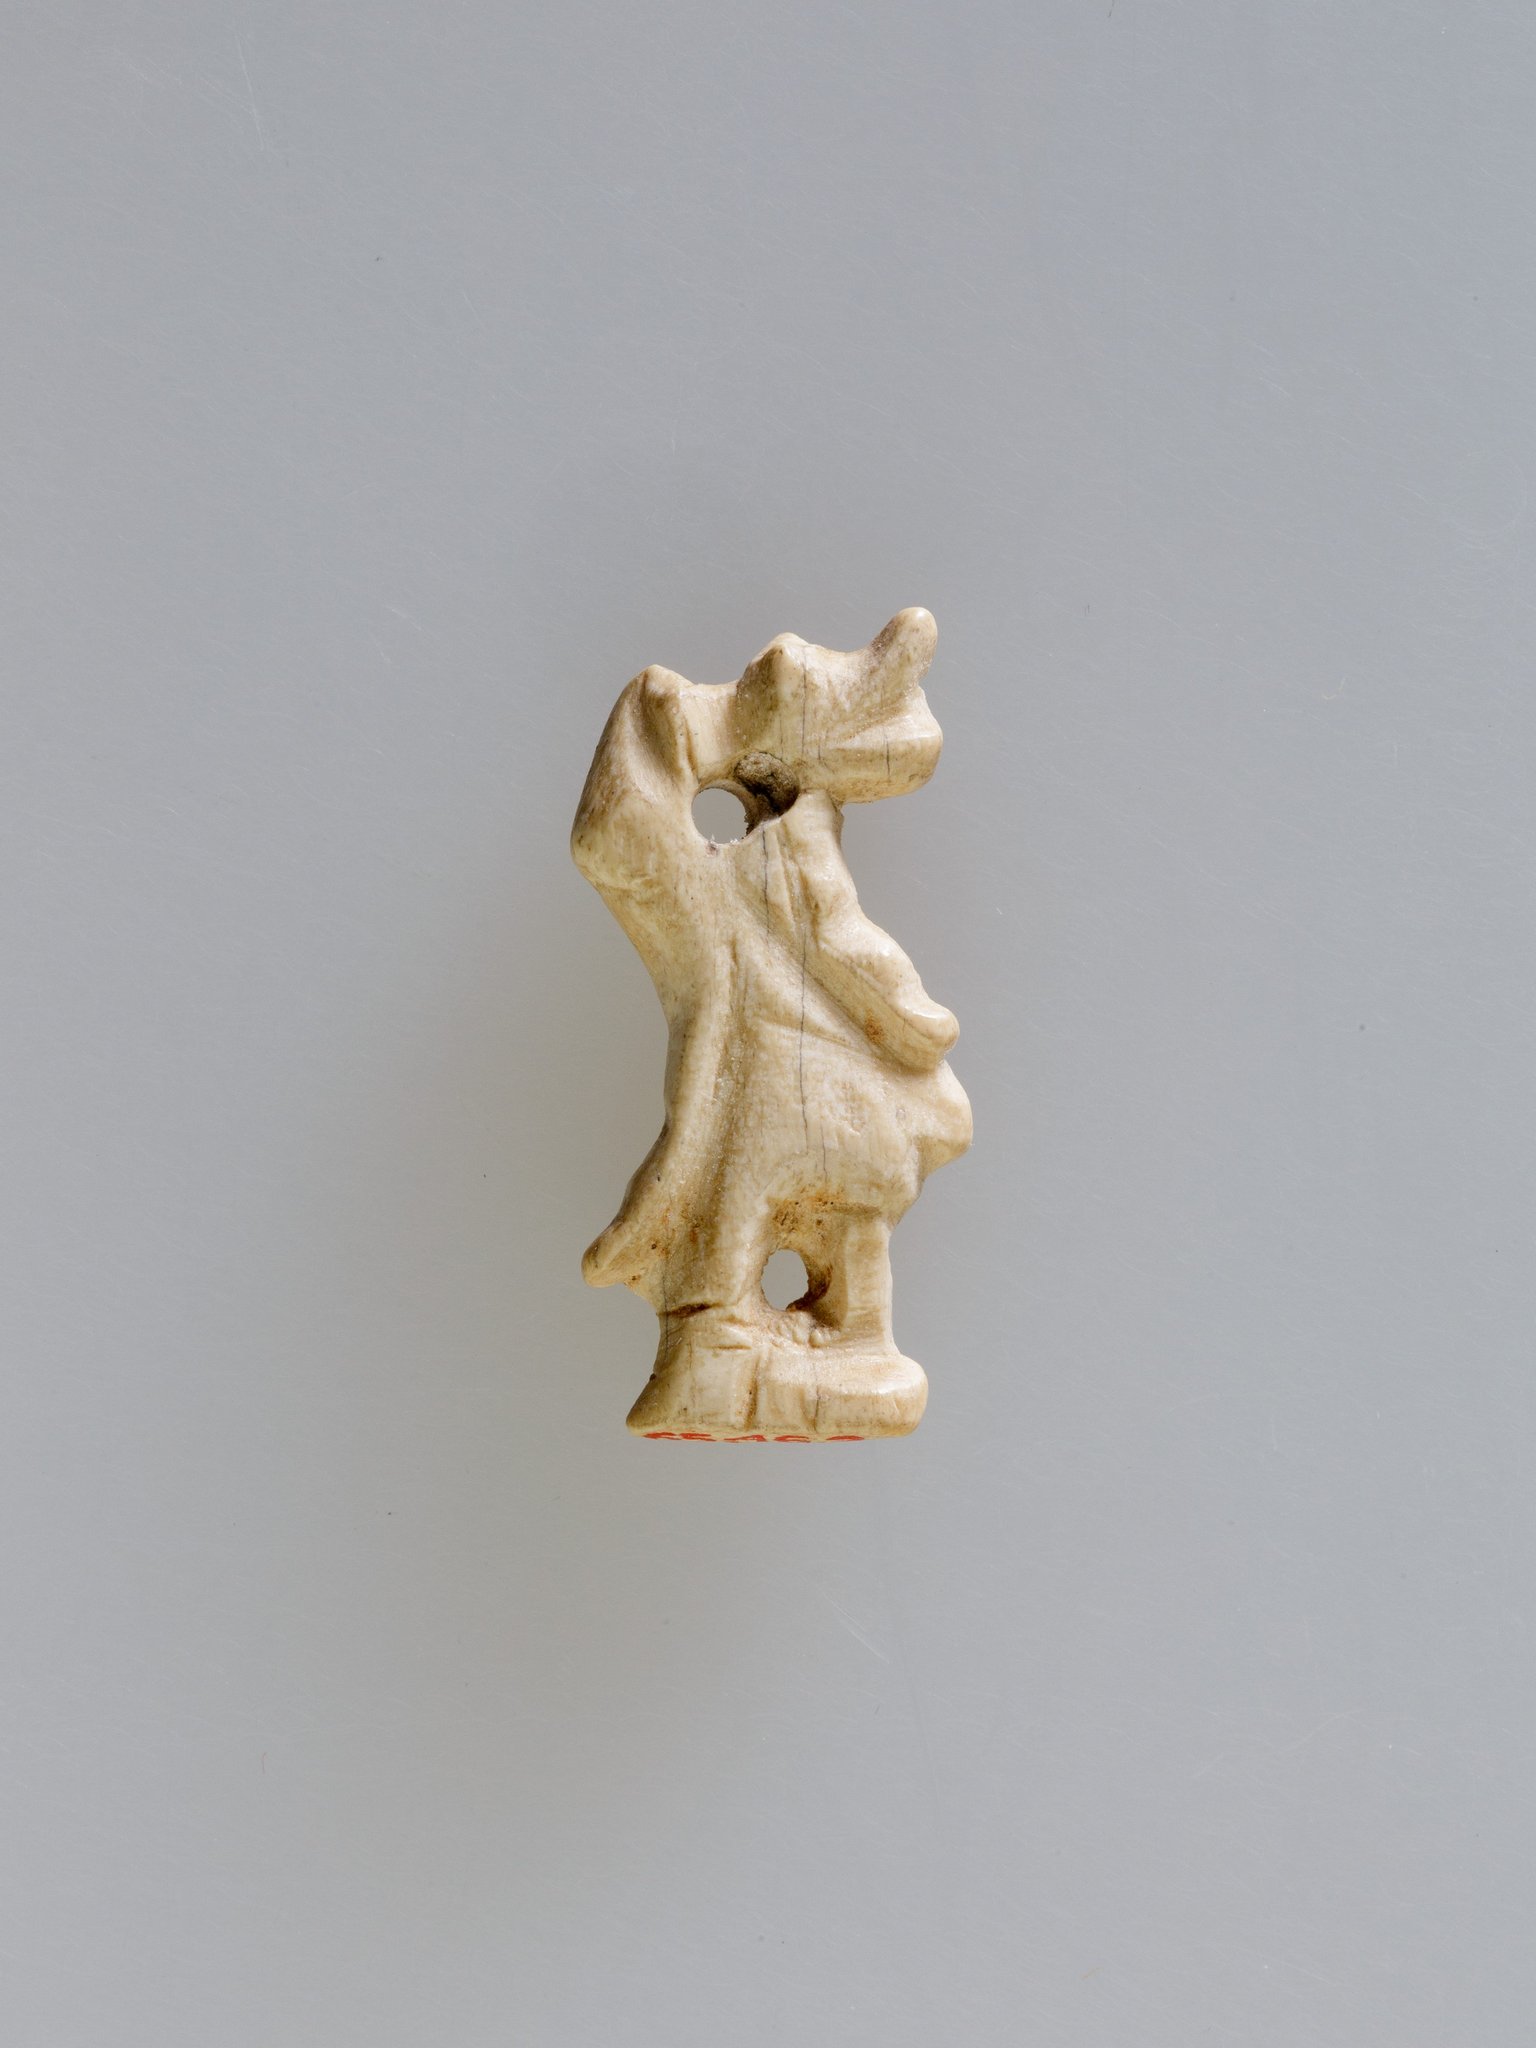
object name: amulet, taweret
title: Taweret amulet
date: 2110-2030 BCE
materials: ivory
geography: egypt